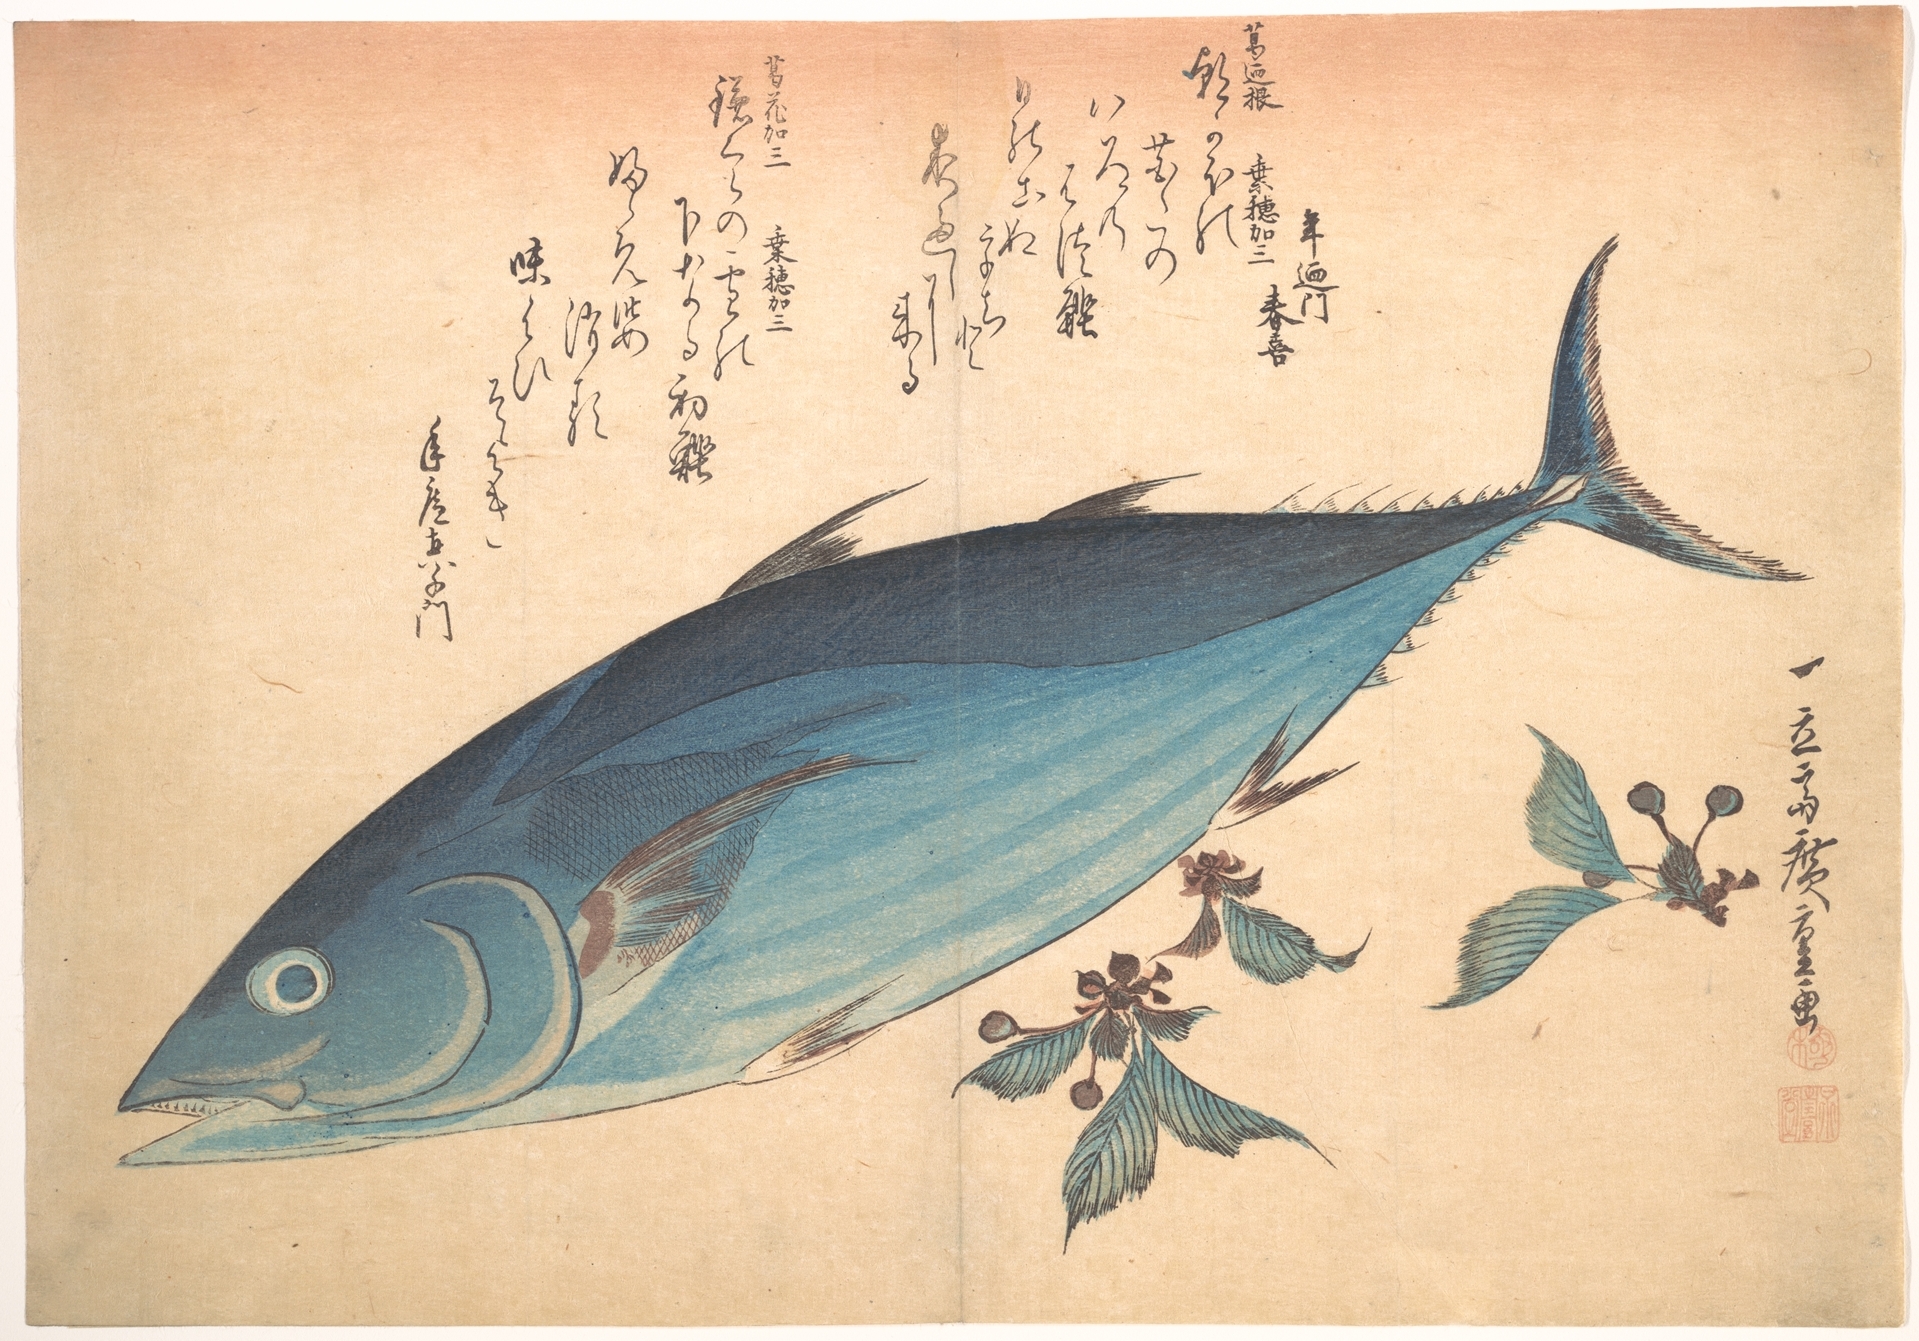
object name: woodblock print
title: Katsuo Fish with Cherry Buds, from the series Uozukushi (Every Variety of Fish)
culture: japanese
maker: utagawa hiroshige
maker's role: artist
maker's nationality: japanese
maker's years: 1797-1858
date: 1830-1839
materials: ink, paper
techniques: woodblock print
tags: fish